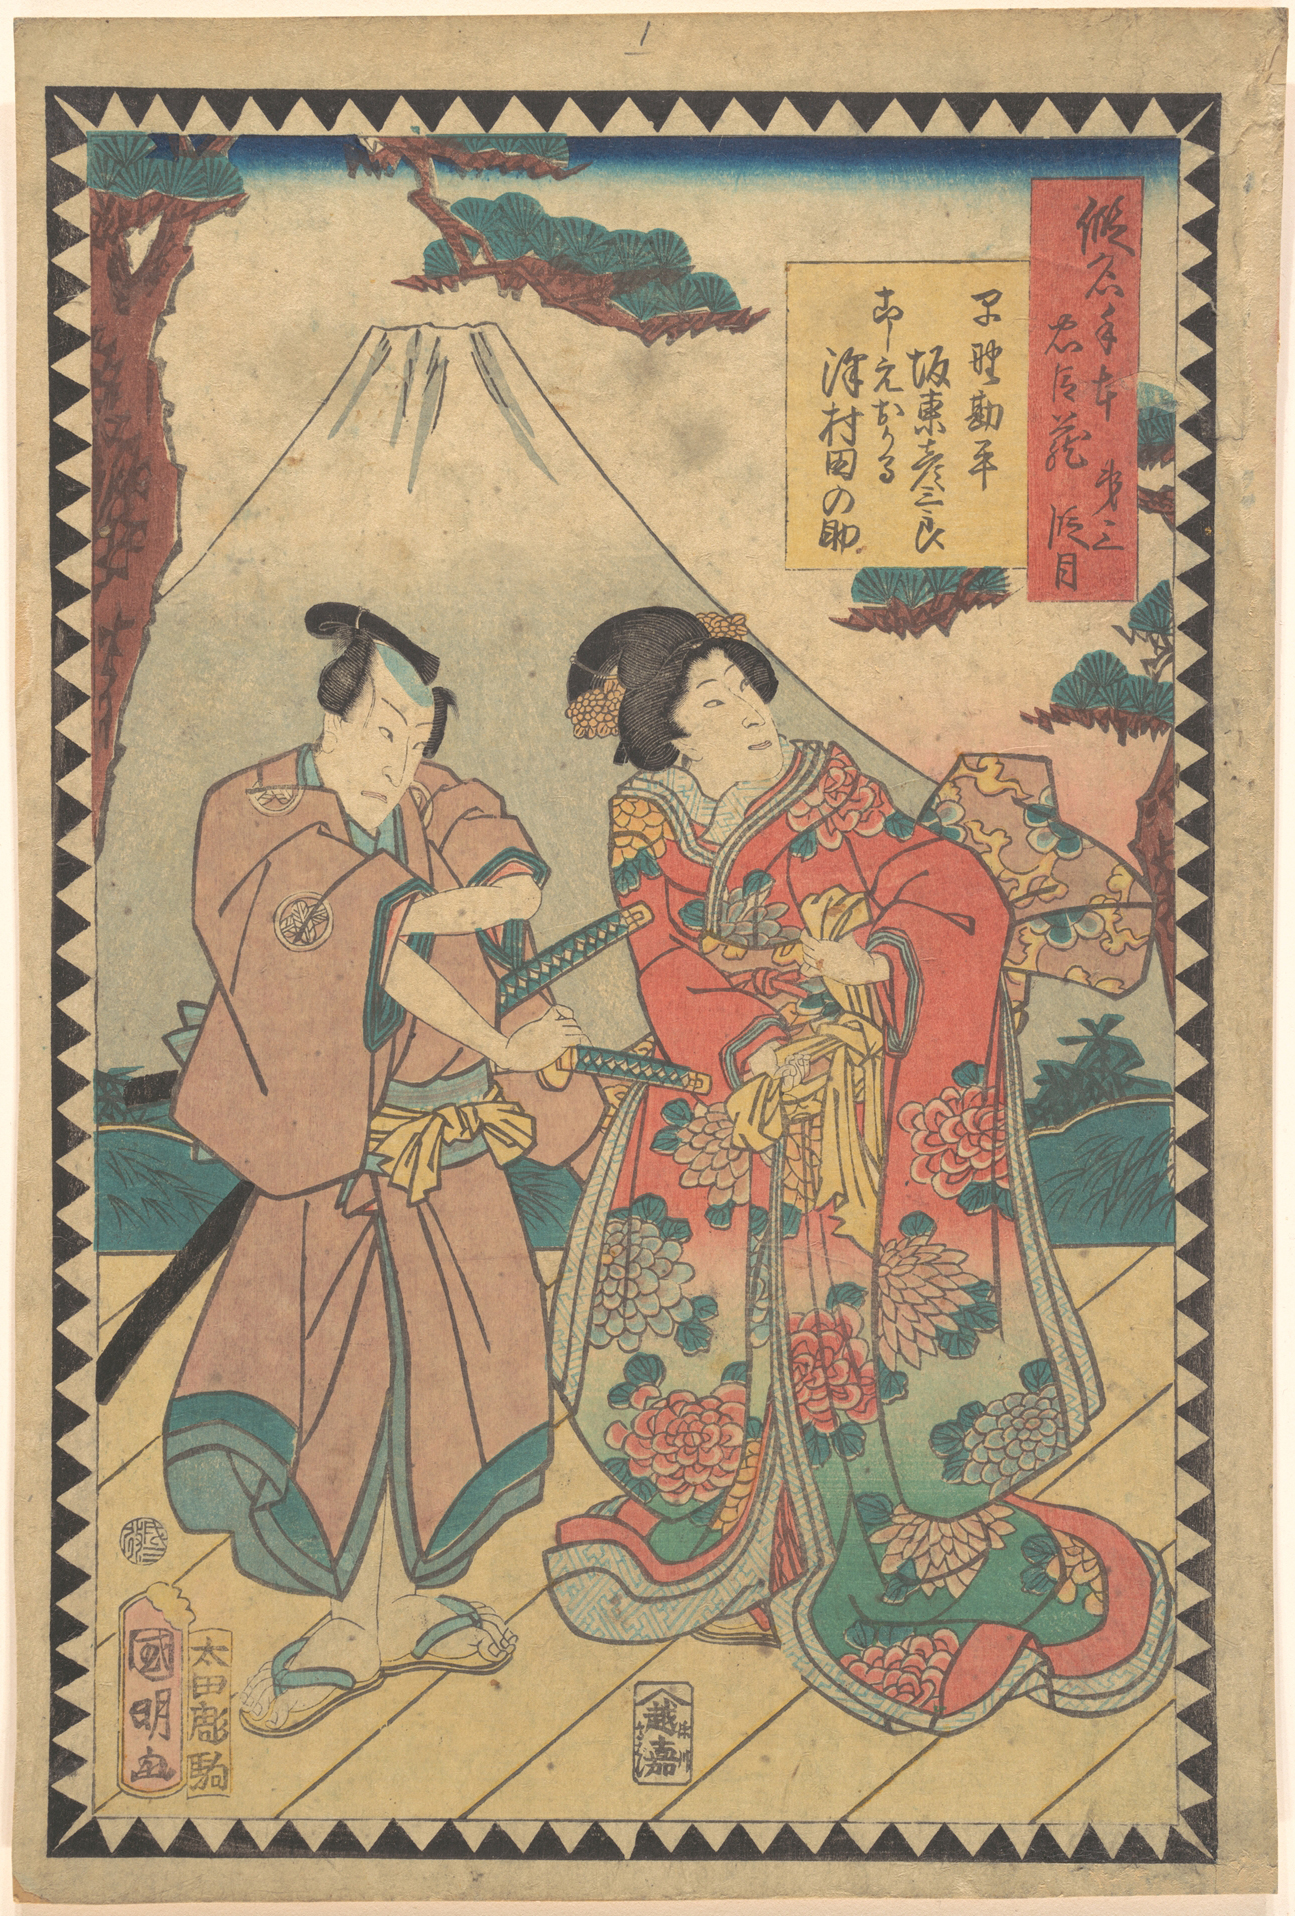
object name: print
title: Act VII (Dai nanadanme): Actors Kataoka Nizaemon VIII as Ōboshi Yuranosuke, Sawamura Tanosuke as Okaru, from the series The Storehouse of Loyal Retainers, a Primer (Kanadehon chūshingura)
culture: japanese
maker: utagawa kuniaki ii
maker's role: artist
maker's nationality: japanese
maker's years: 1835-1888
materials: ink, paper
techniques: woodblock print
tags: men,women,actors